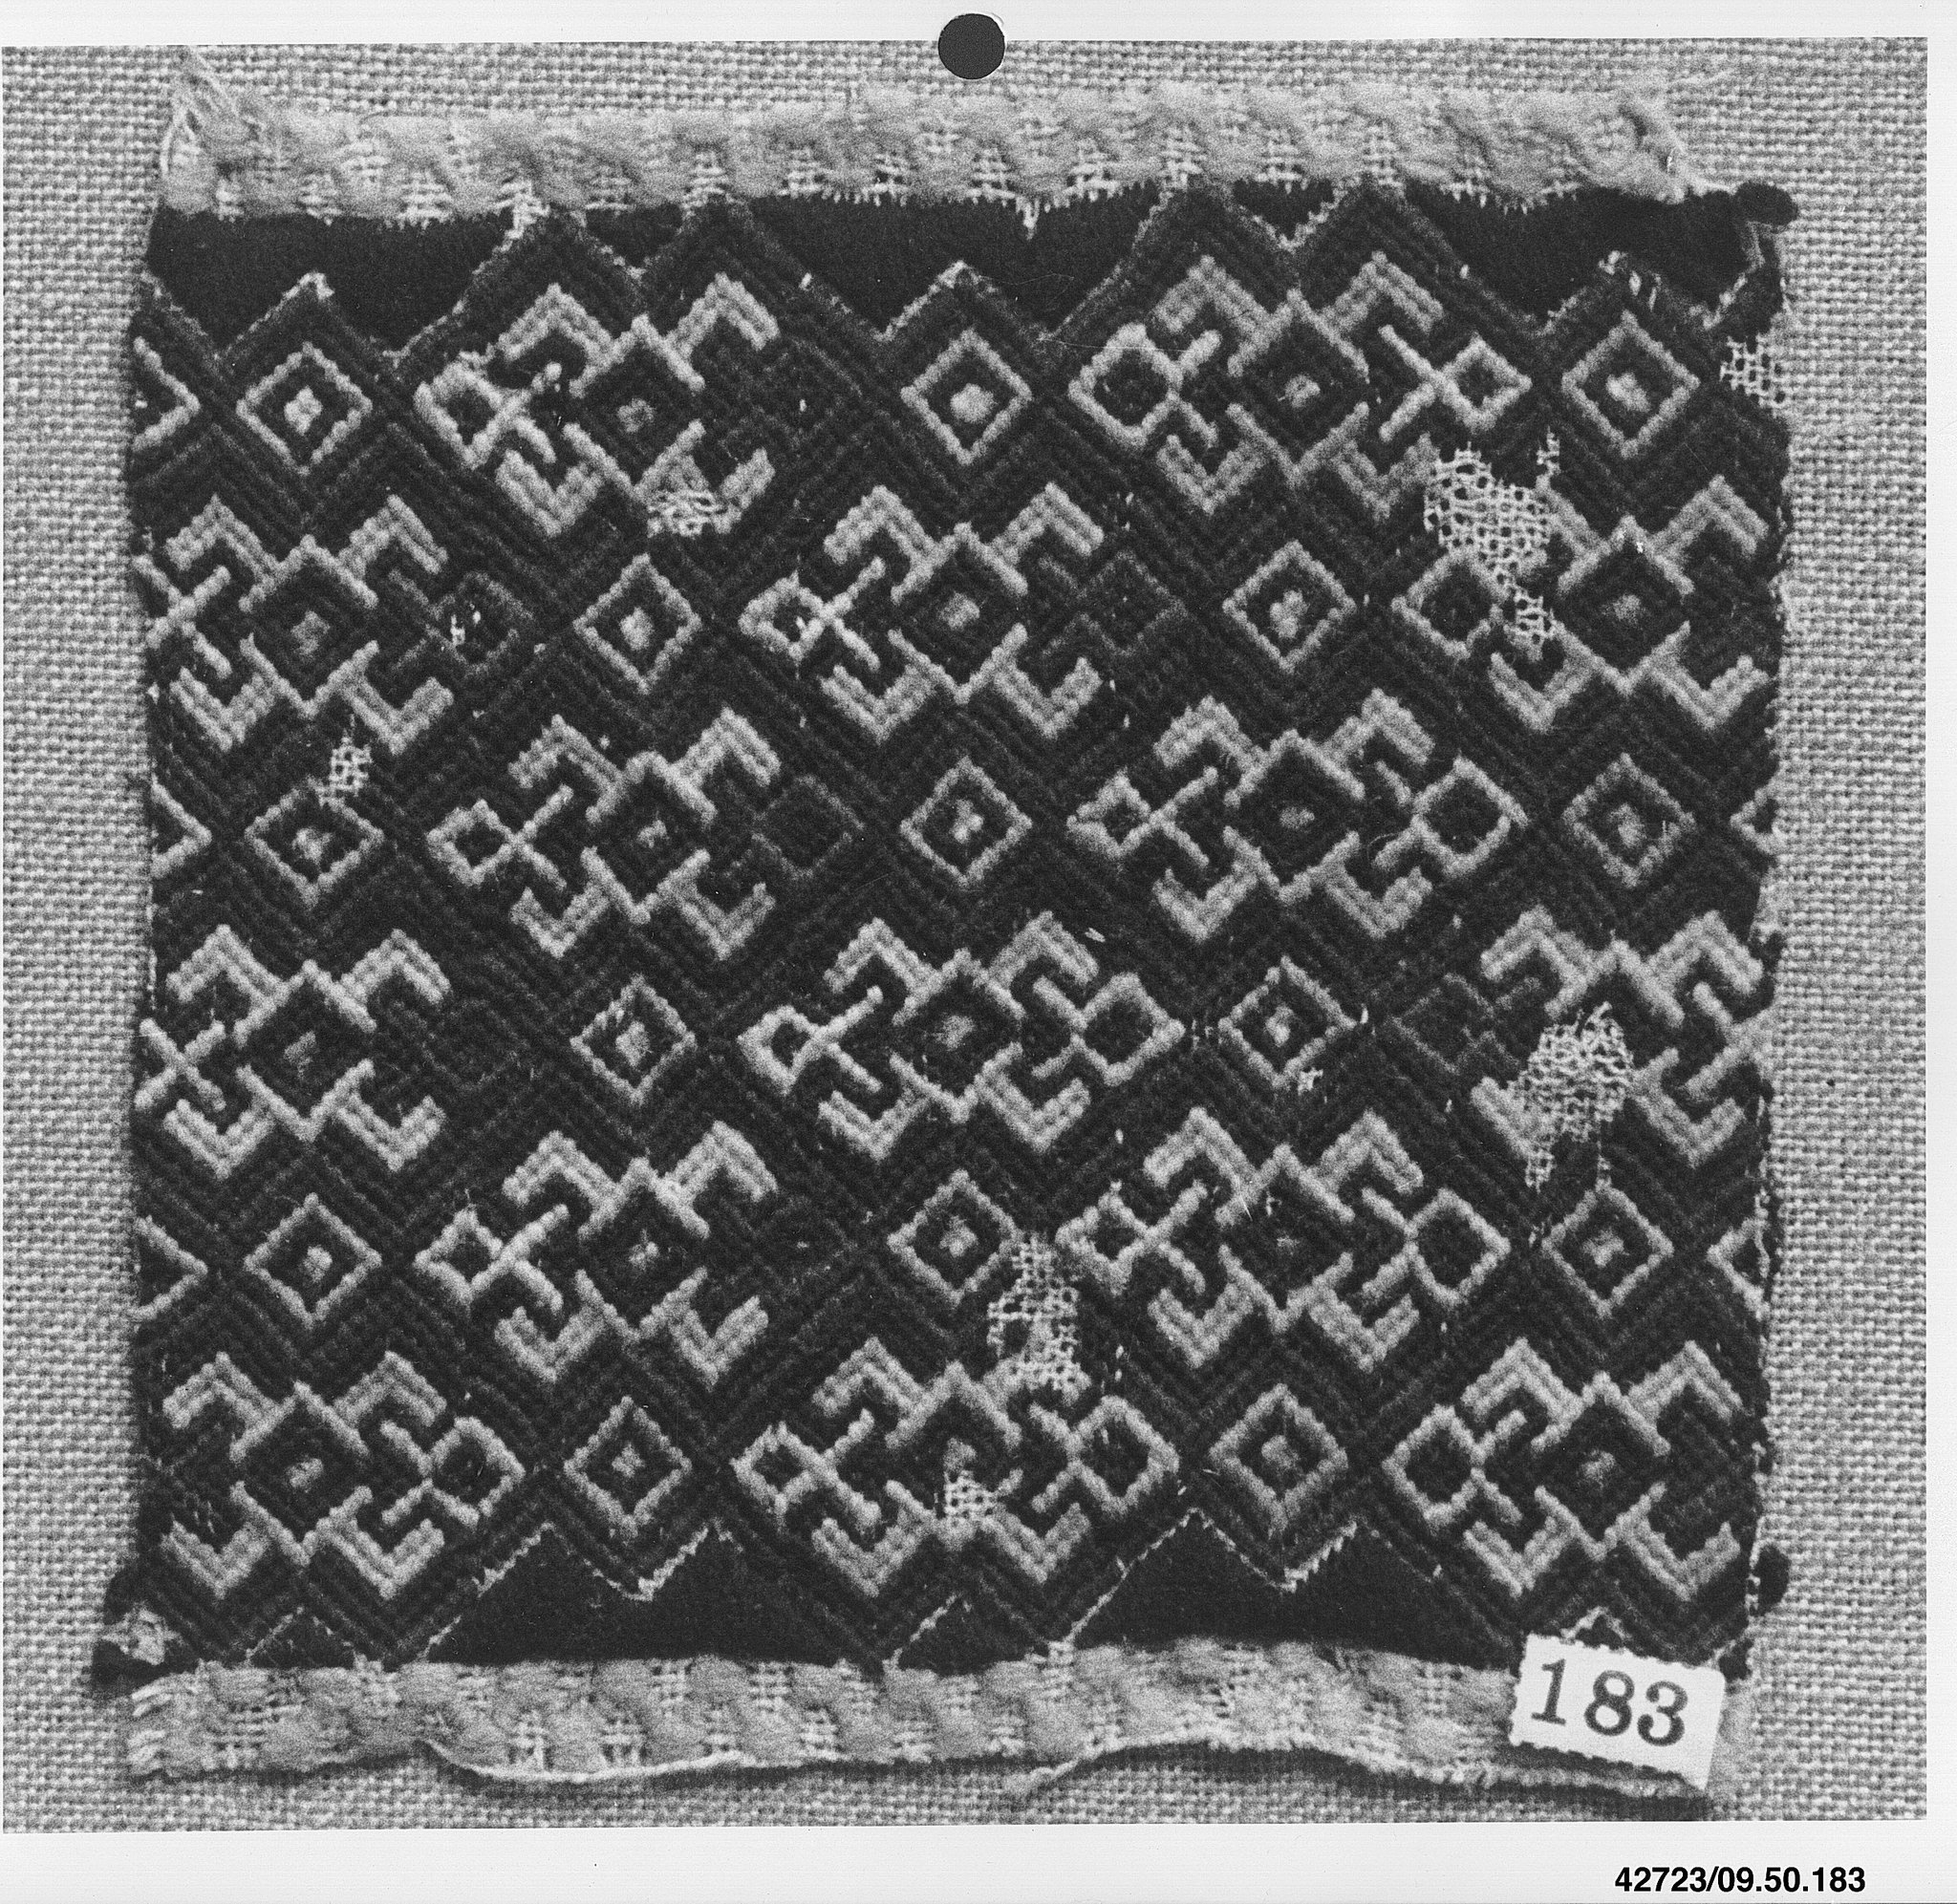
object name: costume fragment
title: Peasant costume fragment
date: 1701-1900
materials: canvas, wool